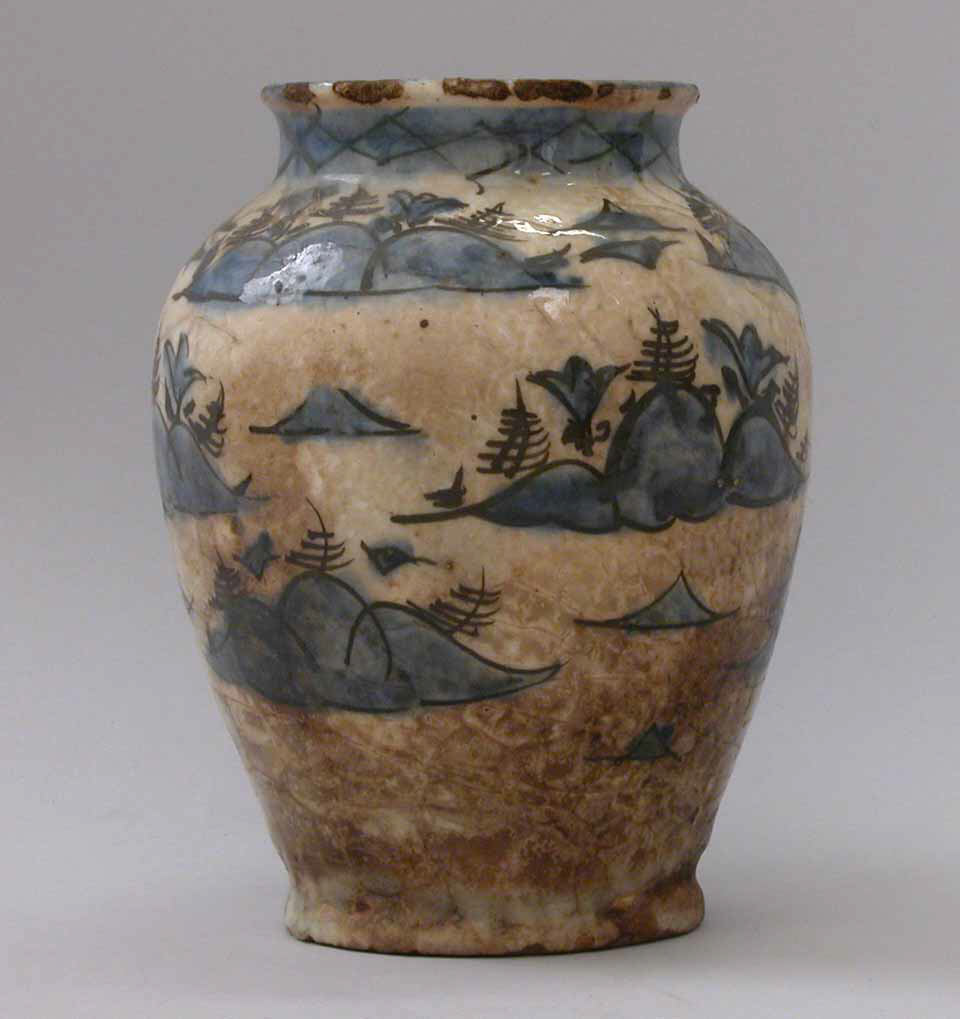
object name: jar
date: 1601-1800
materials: stonepaste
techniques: painting, underglaze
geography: iran